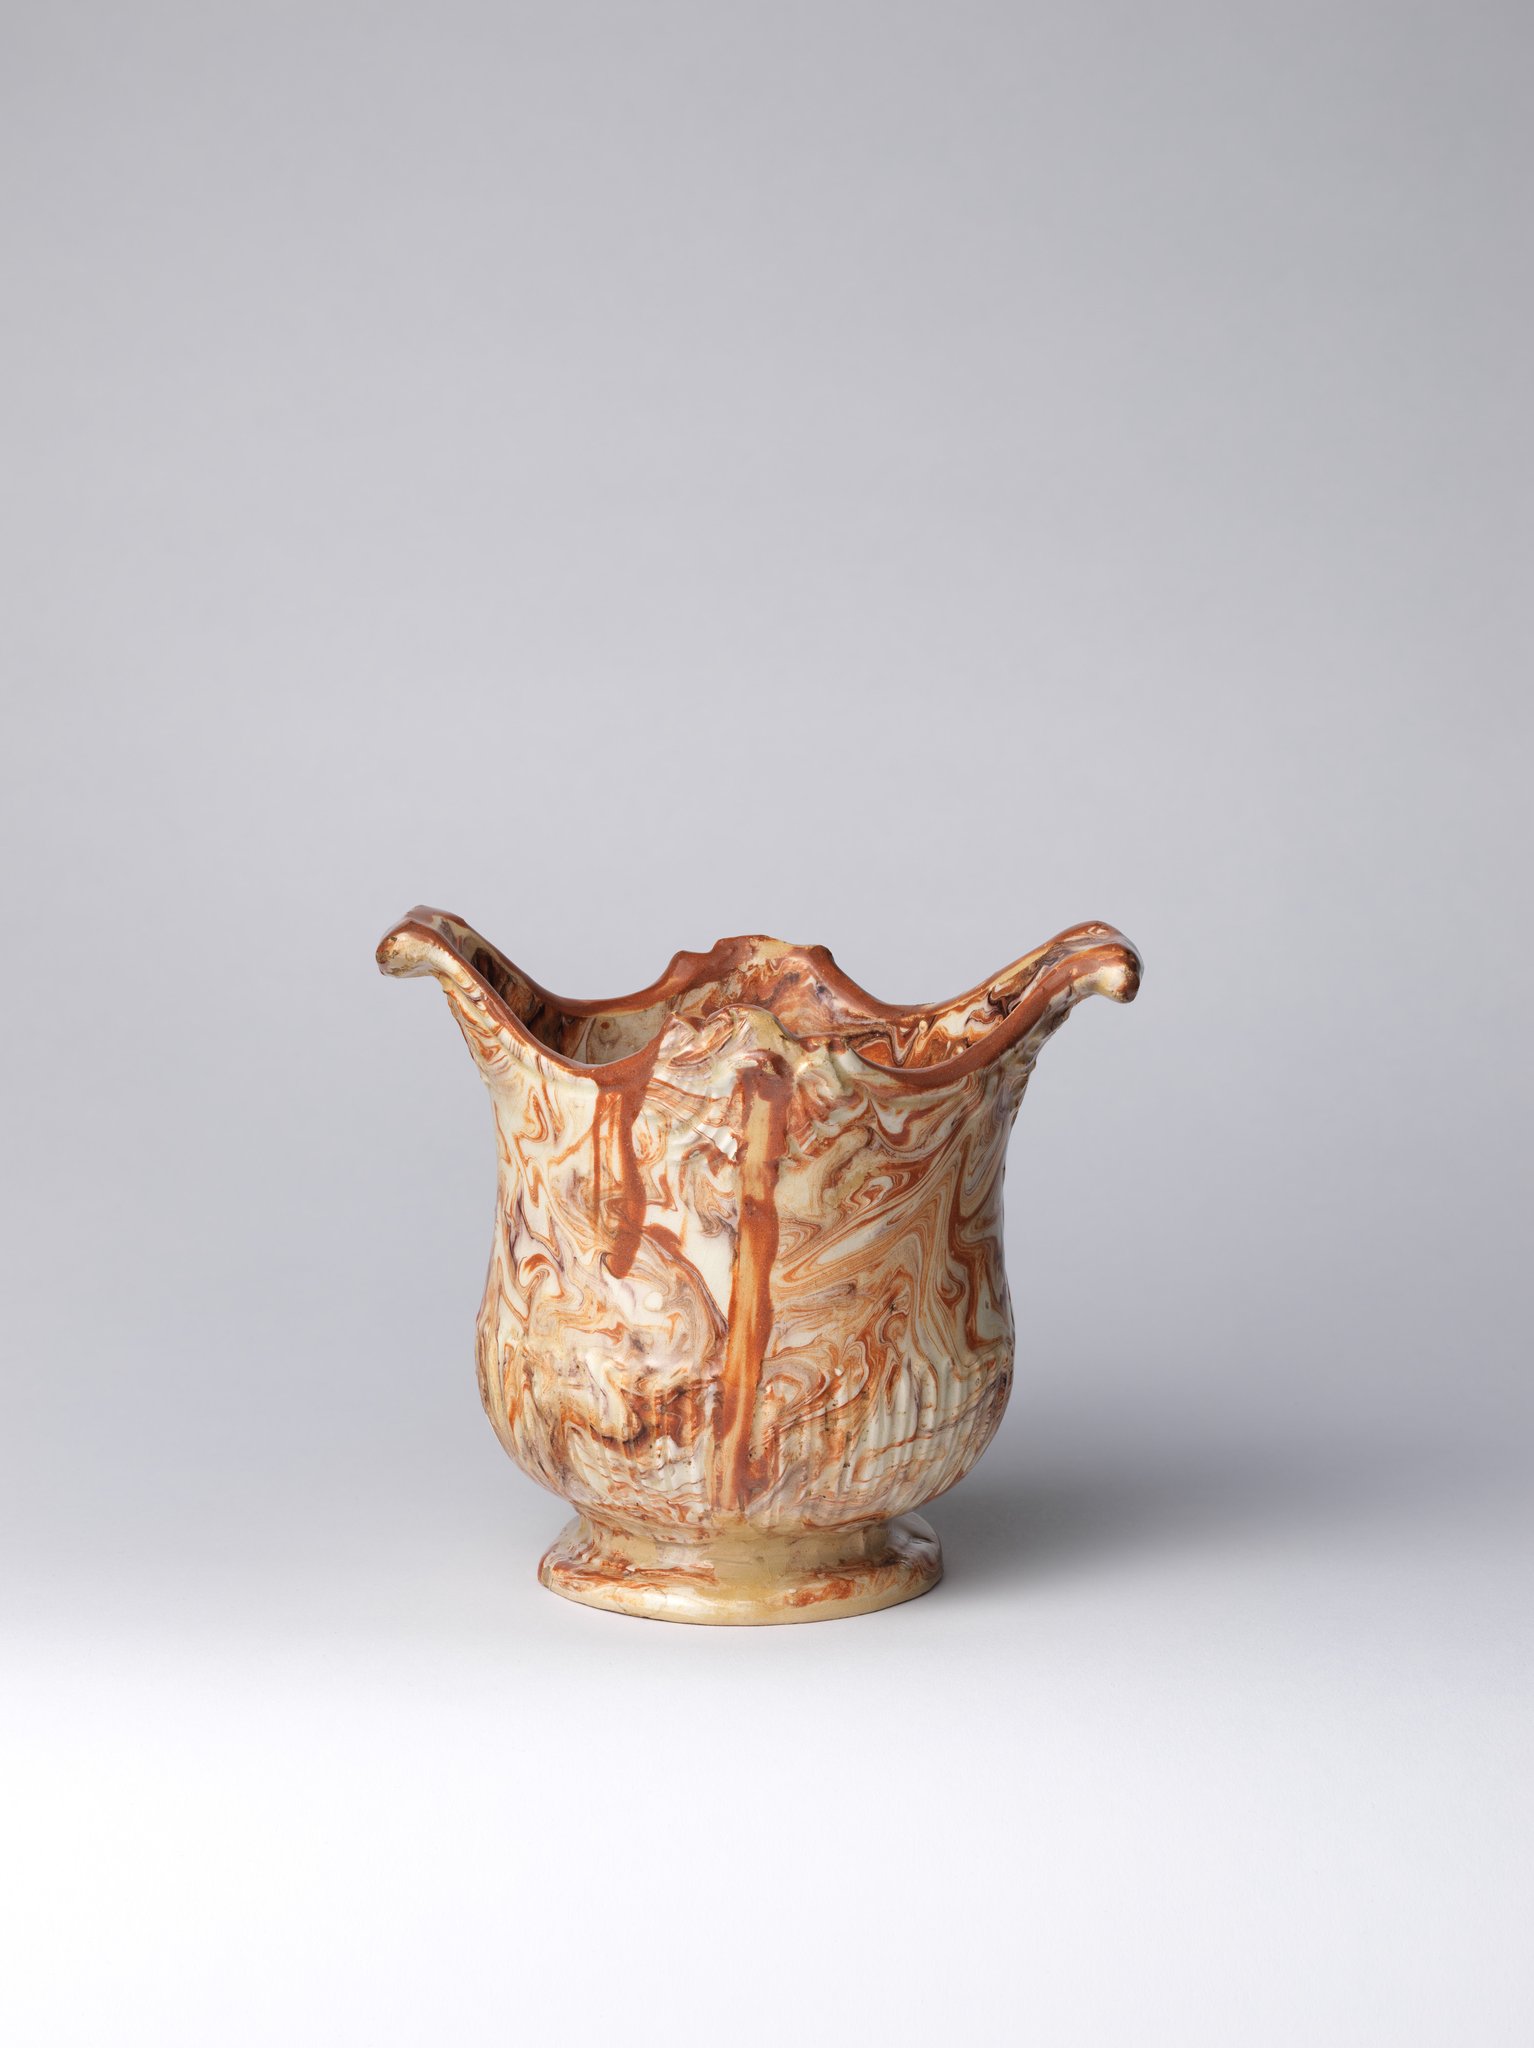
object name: ice bucket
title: Ice bucket (Seau à bouteille)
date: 1765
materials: faience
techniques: glazing